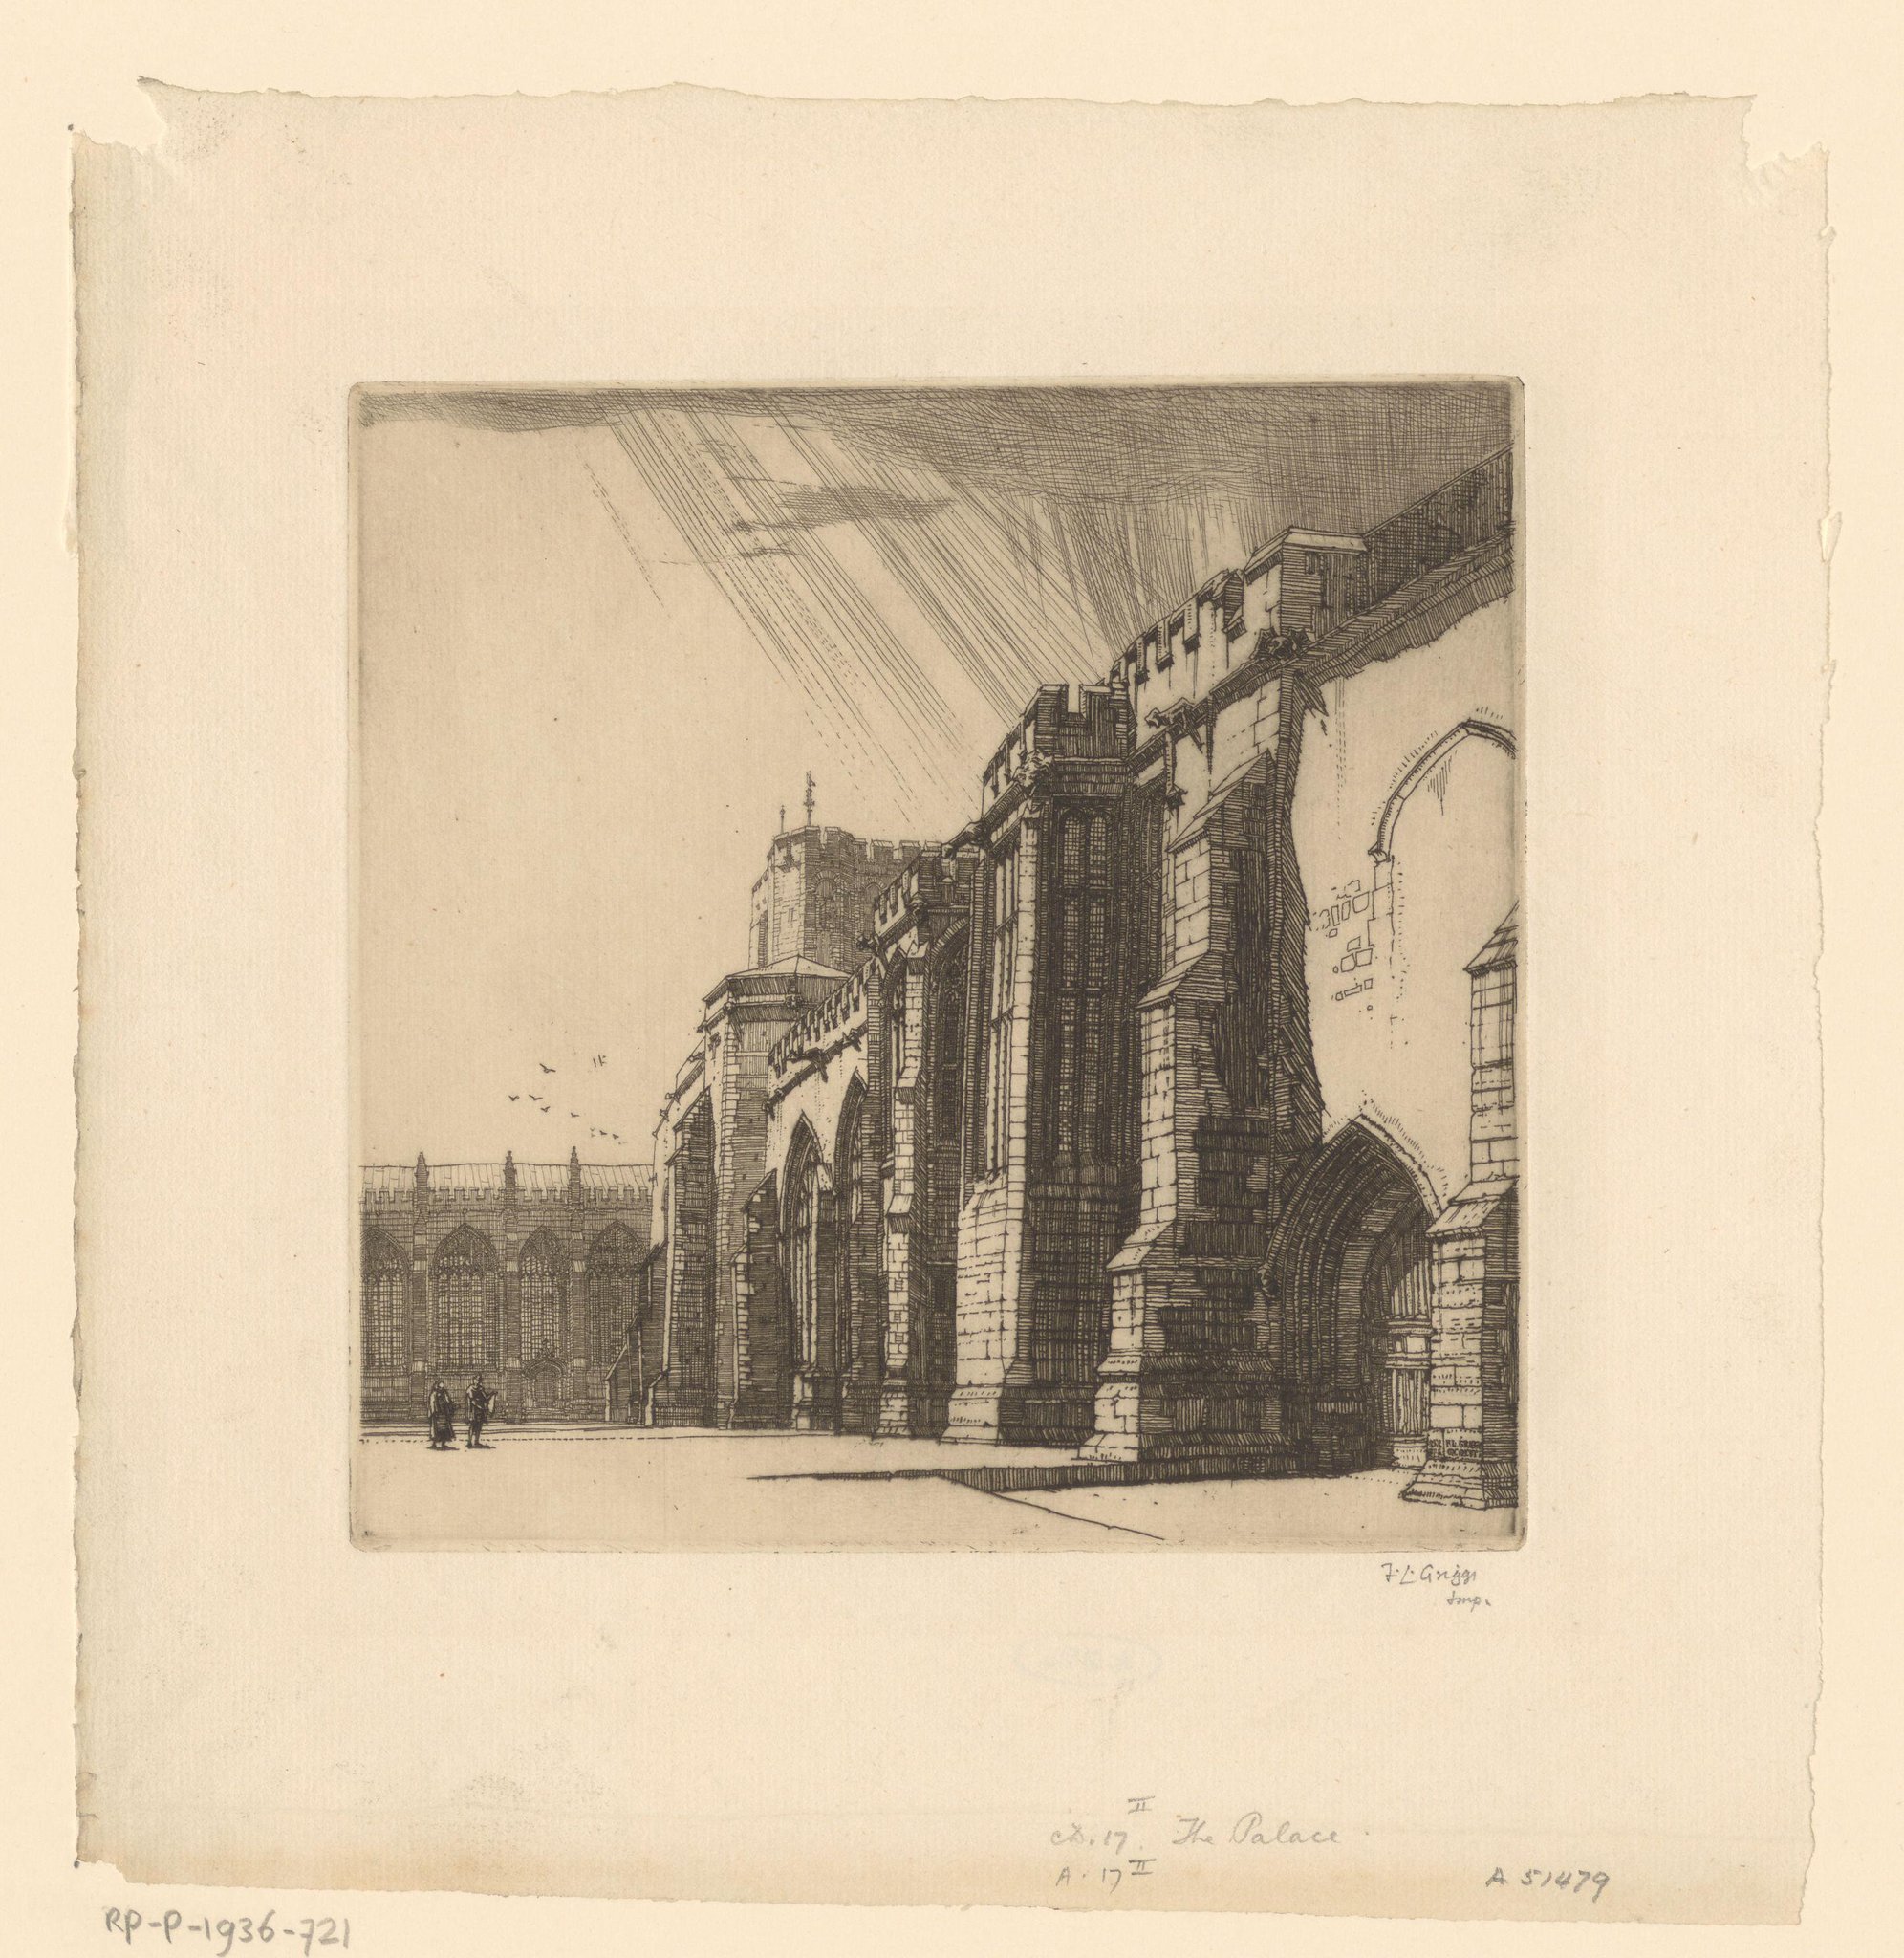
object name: print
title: Façade van een paleis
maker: frederick landseer maur griggs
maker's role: print maker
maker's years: 1876-1938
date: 1916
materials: paper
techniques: etching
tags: palace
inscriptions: collector's mark: Lugt 2228